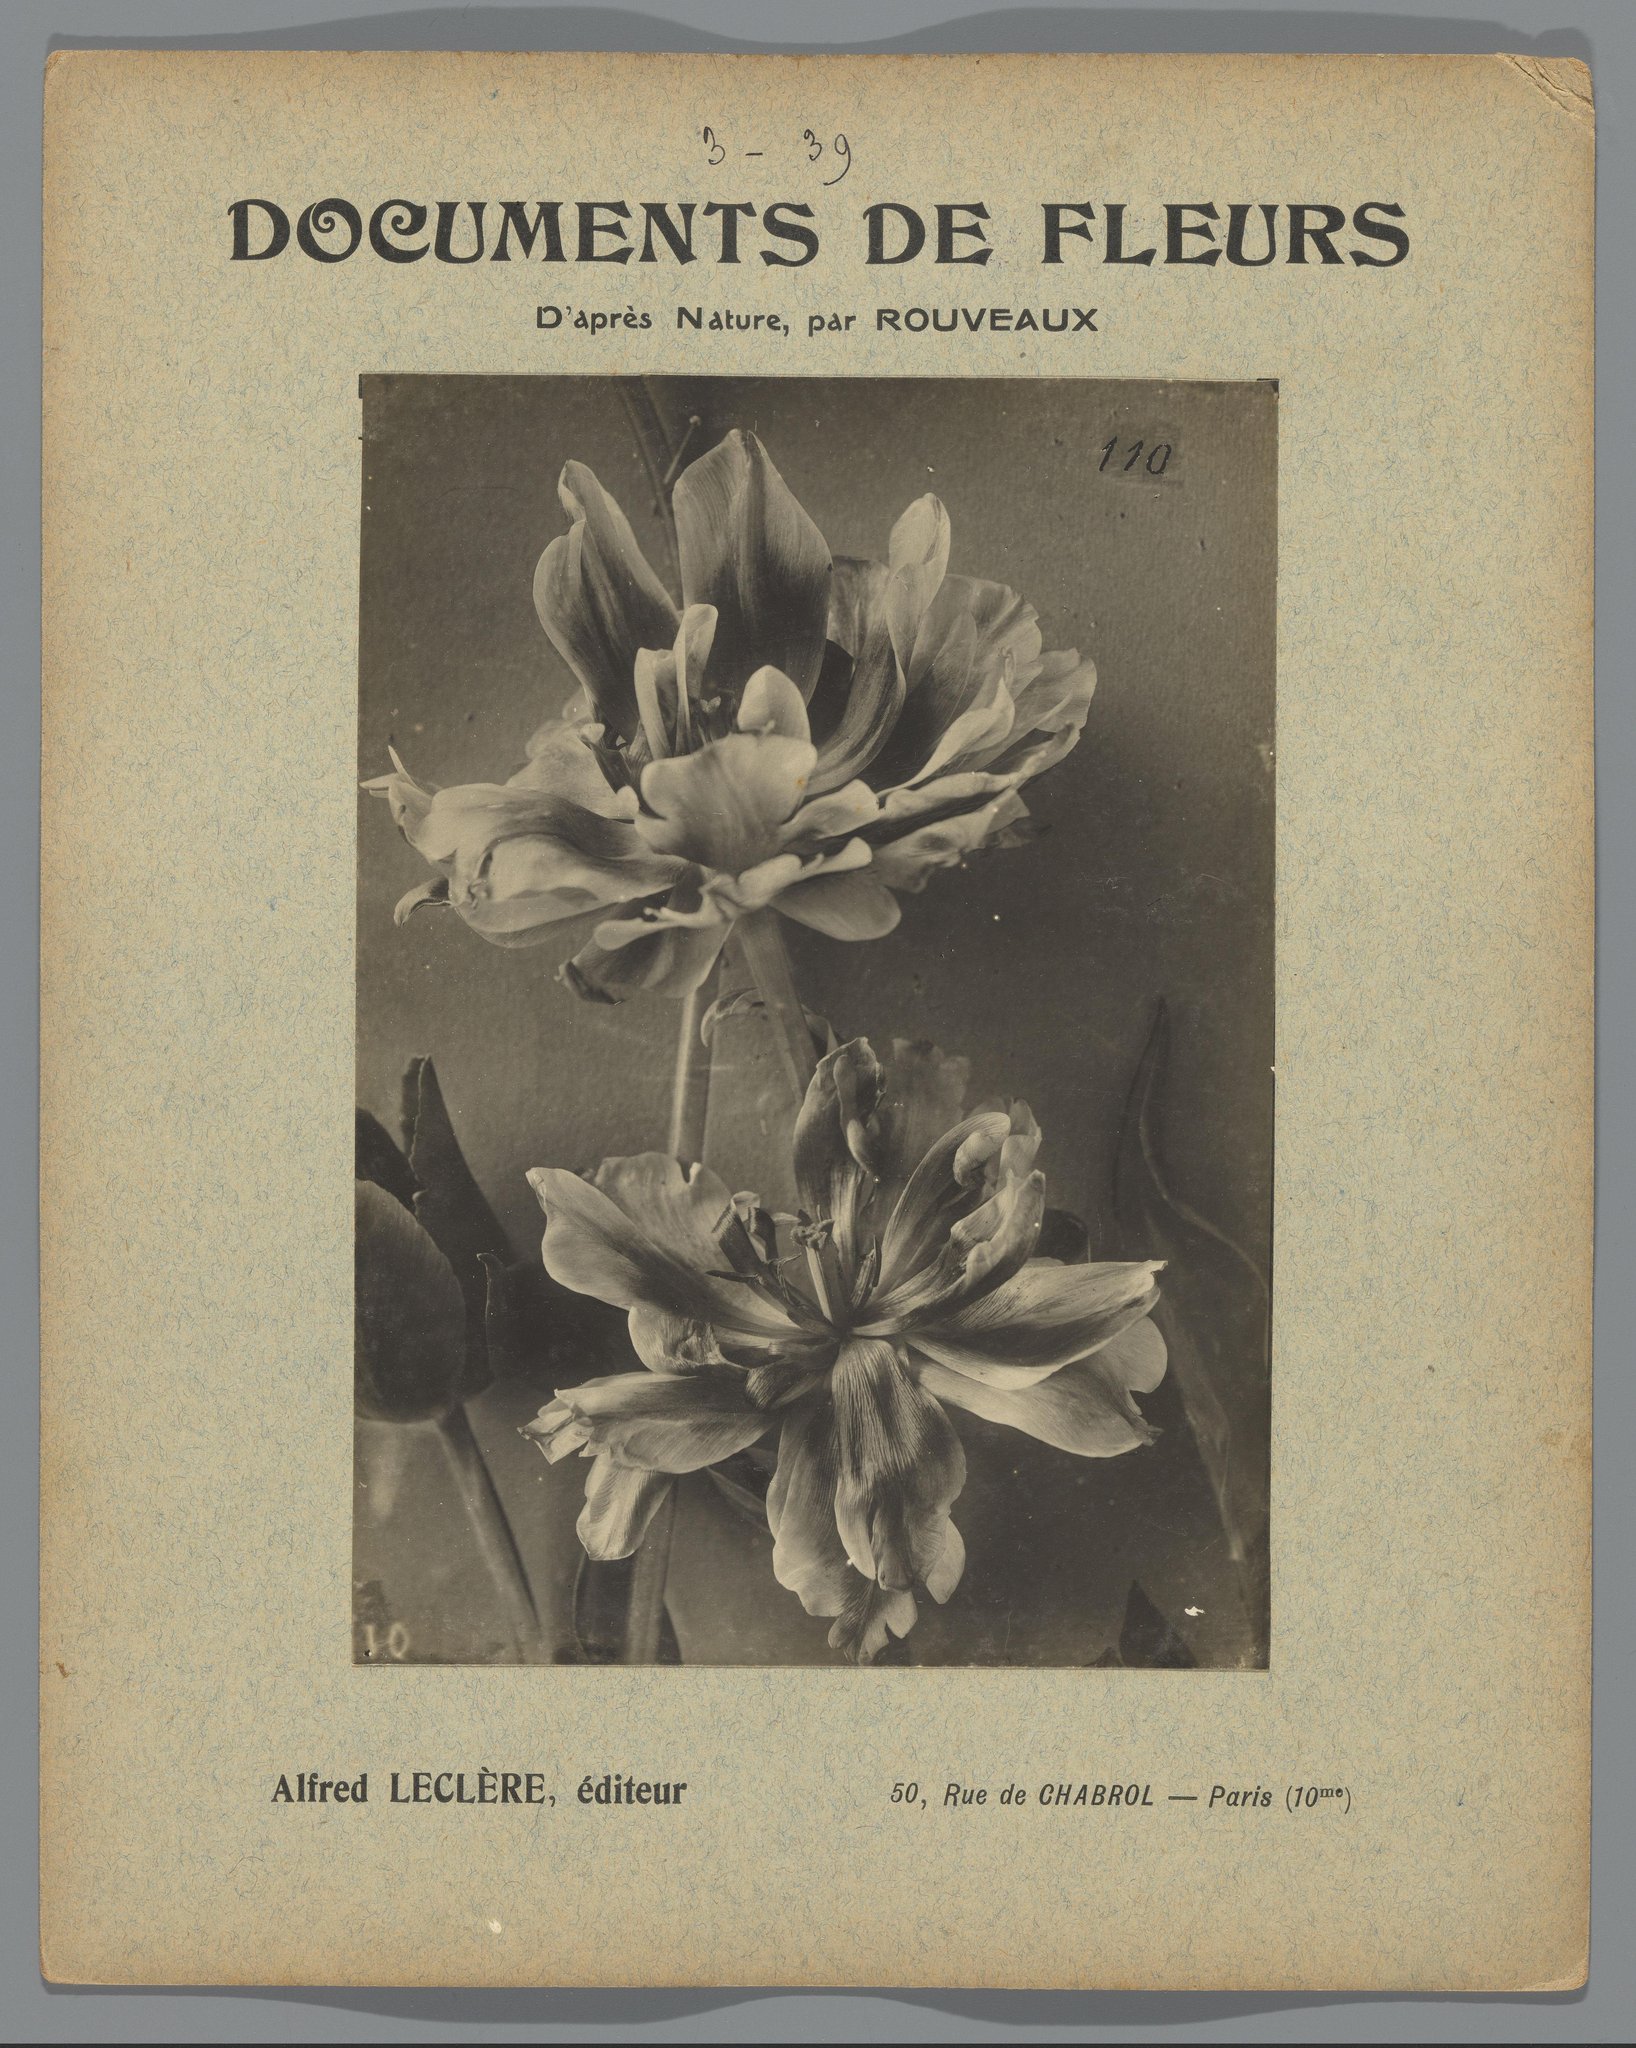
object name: photograph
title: Bloemstudie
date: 1895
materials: photographic support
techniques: gelatin silver print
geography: france